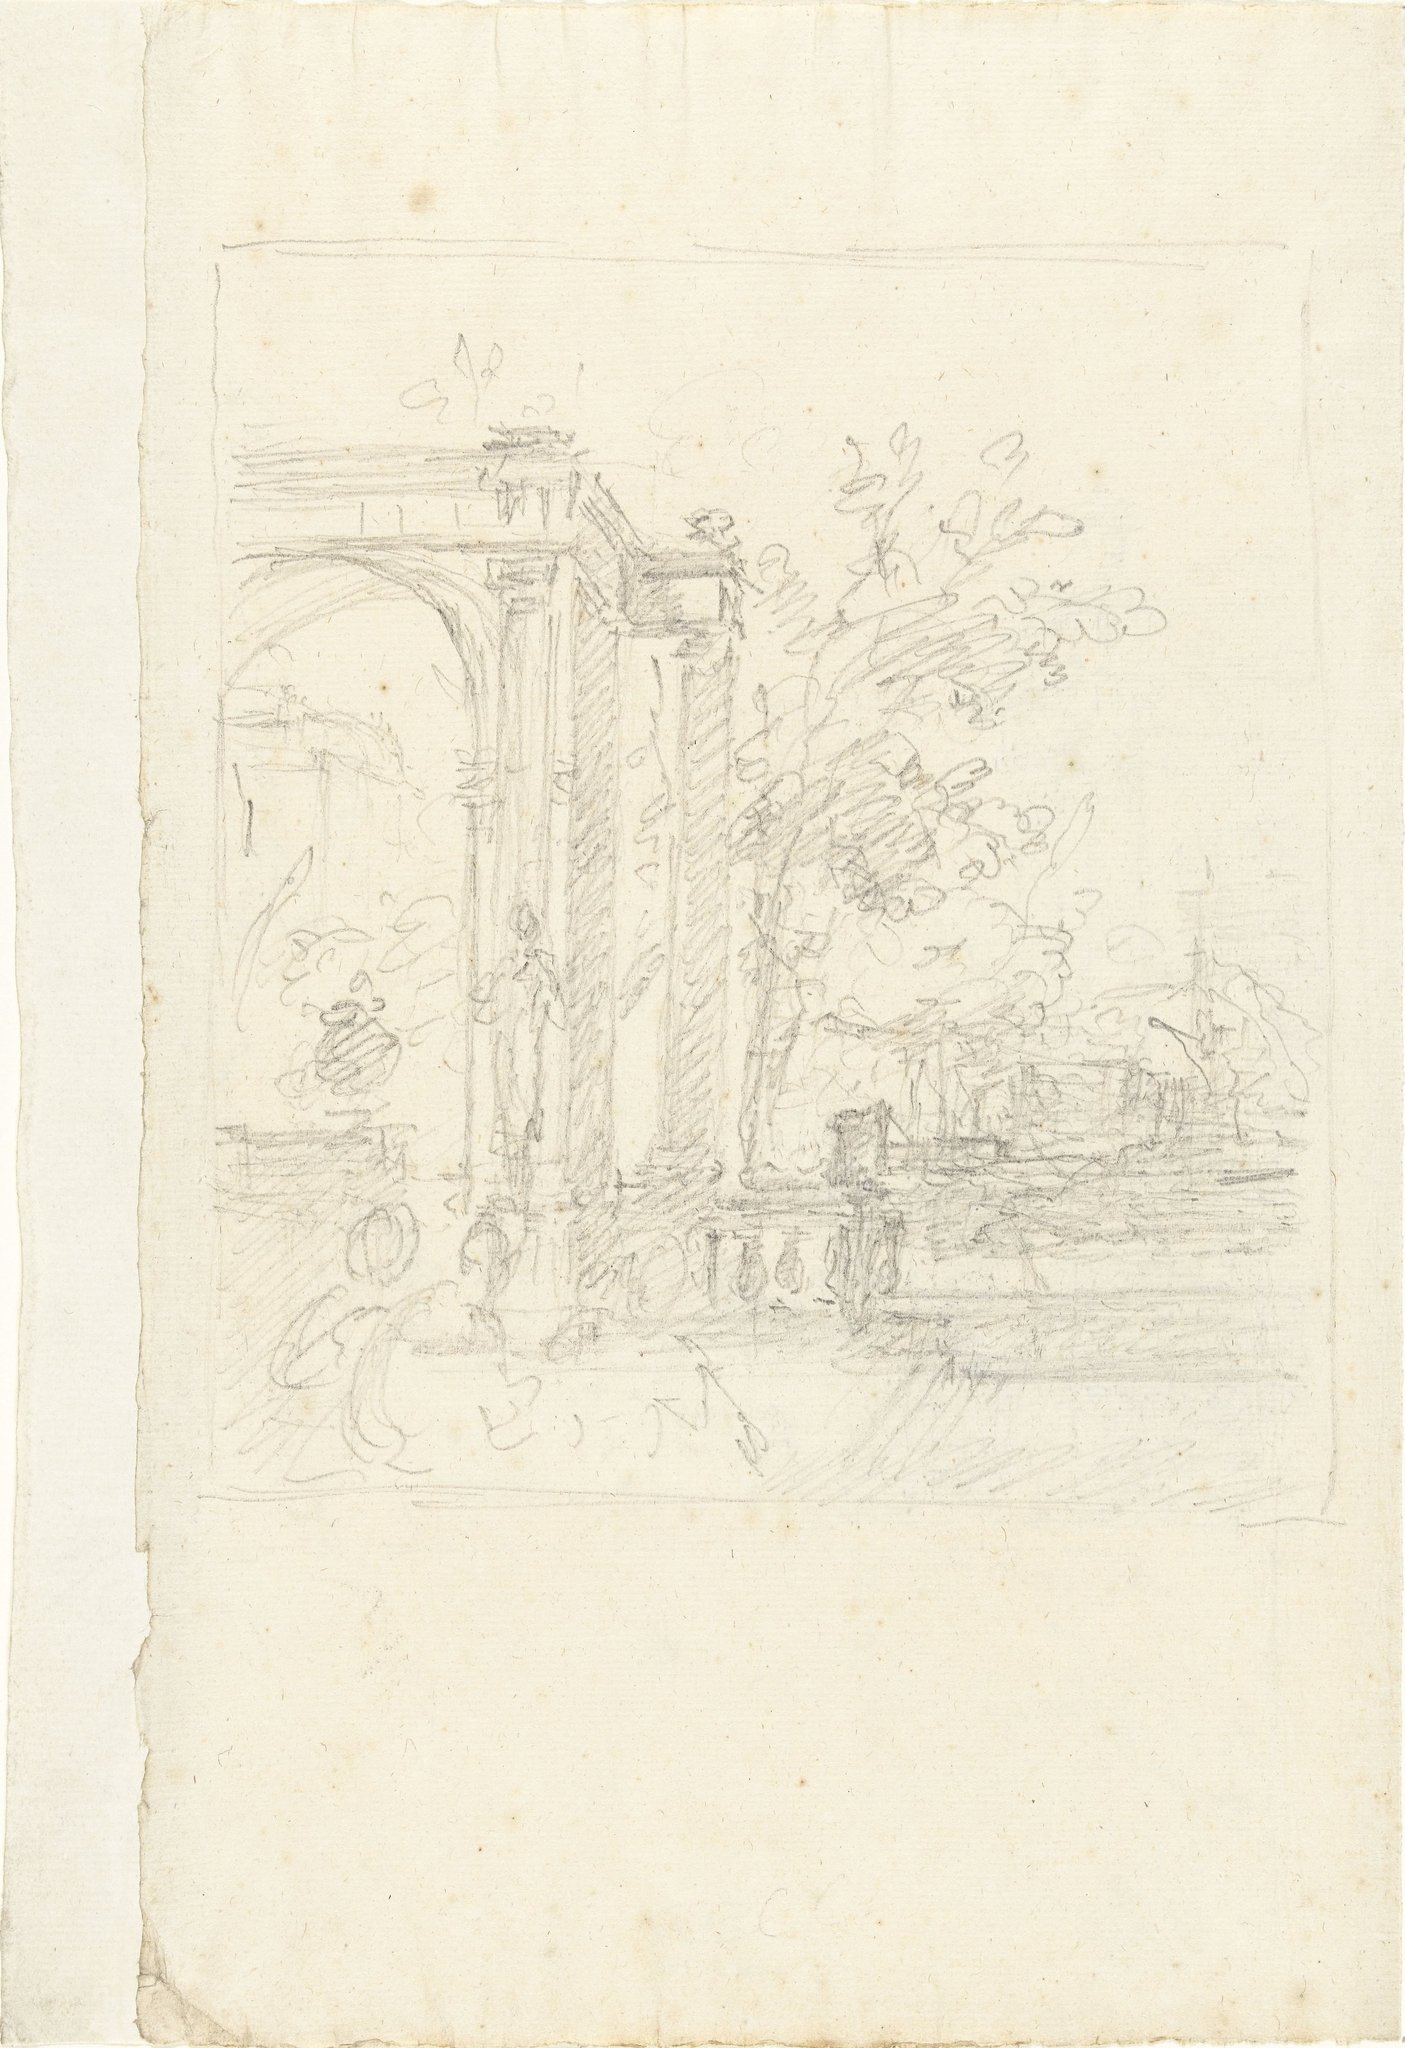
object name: drawing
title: Portico met beelden en tuin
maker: dionys van nijmegen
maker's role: draughtsman, painter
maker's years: 1705-1798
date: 1715-1798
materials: paper, pencil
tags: garden